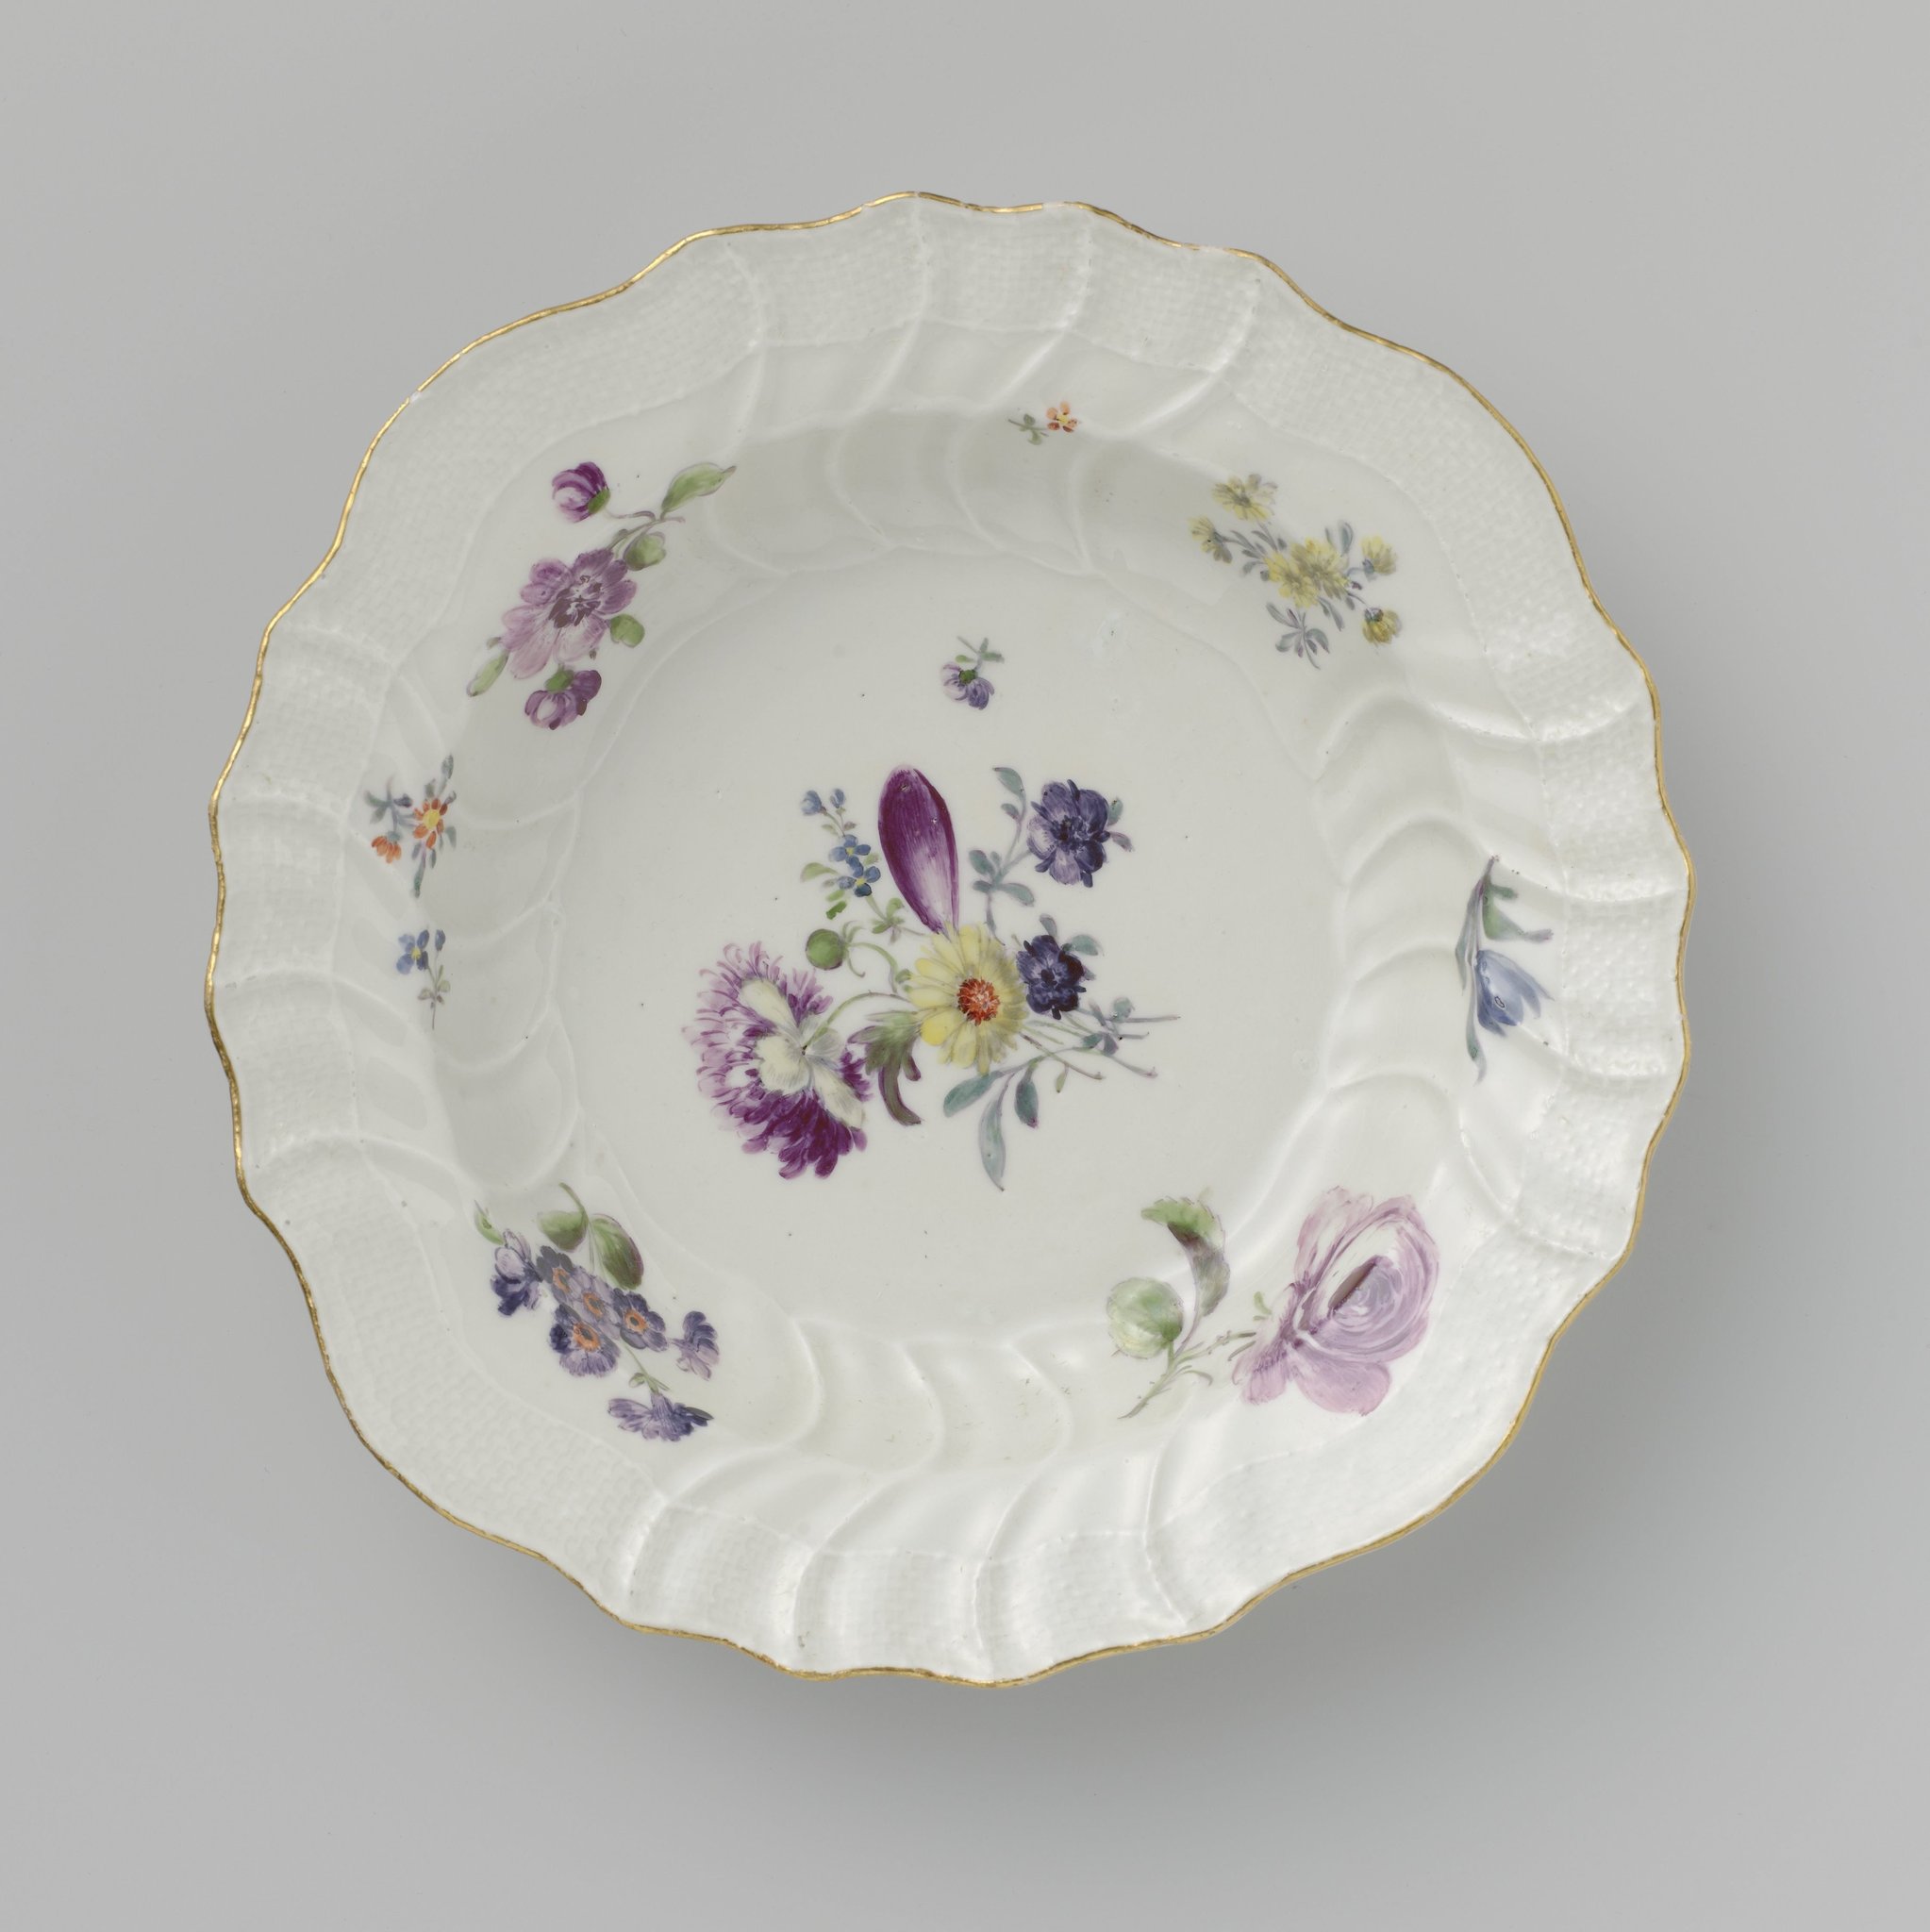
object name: plate dish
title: Bord, veelkleurig beschilderd met Deutsche Blumen, insekten en vruchten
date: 1750-1760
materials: porcelain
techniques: painted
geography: meissen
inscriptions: factory mark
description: Rond soepbord van beschilderd porselein. Het bord is beschilderd met Deutsche Blumen, insekten en vruchten. De rand is in reliëf versierd met het Neuozier-patroon. Het bord is gemerkt en hoort bij een servies (BK-17474-1 t/m BK-17474-253).